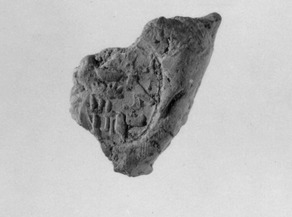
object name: sealing, amenhotep ii, aakheperure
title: Document Sealings With the Throne Name of Amenhotep II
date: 1390-1352 BCE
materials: mud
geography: egypt